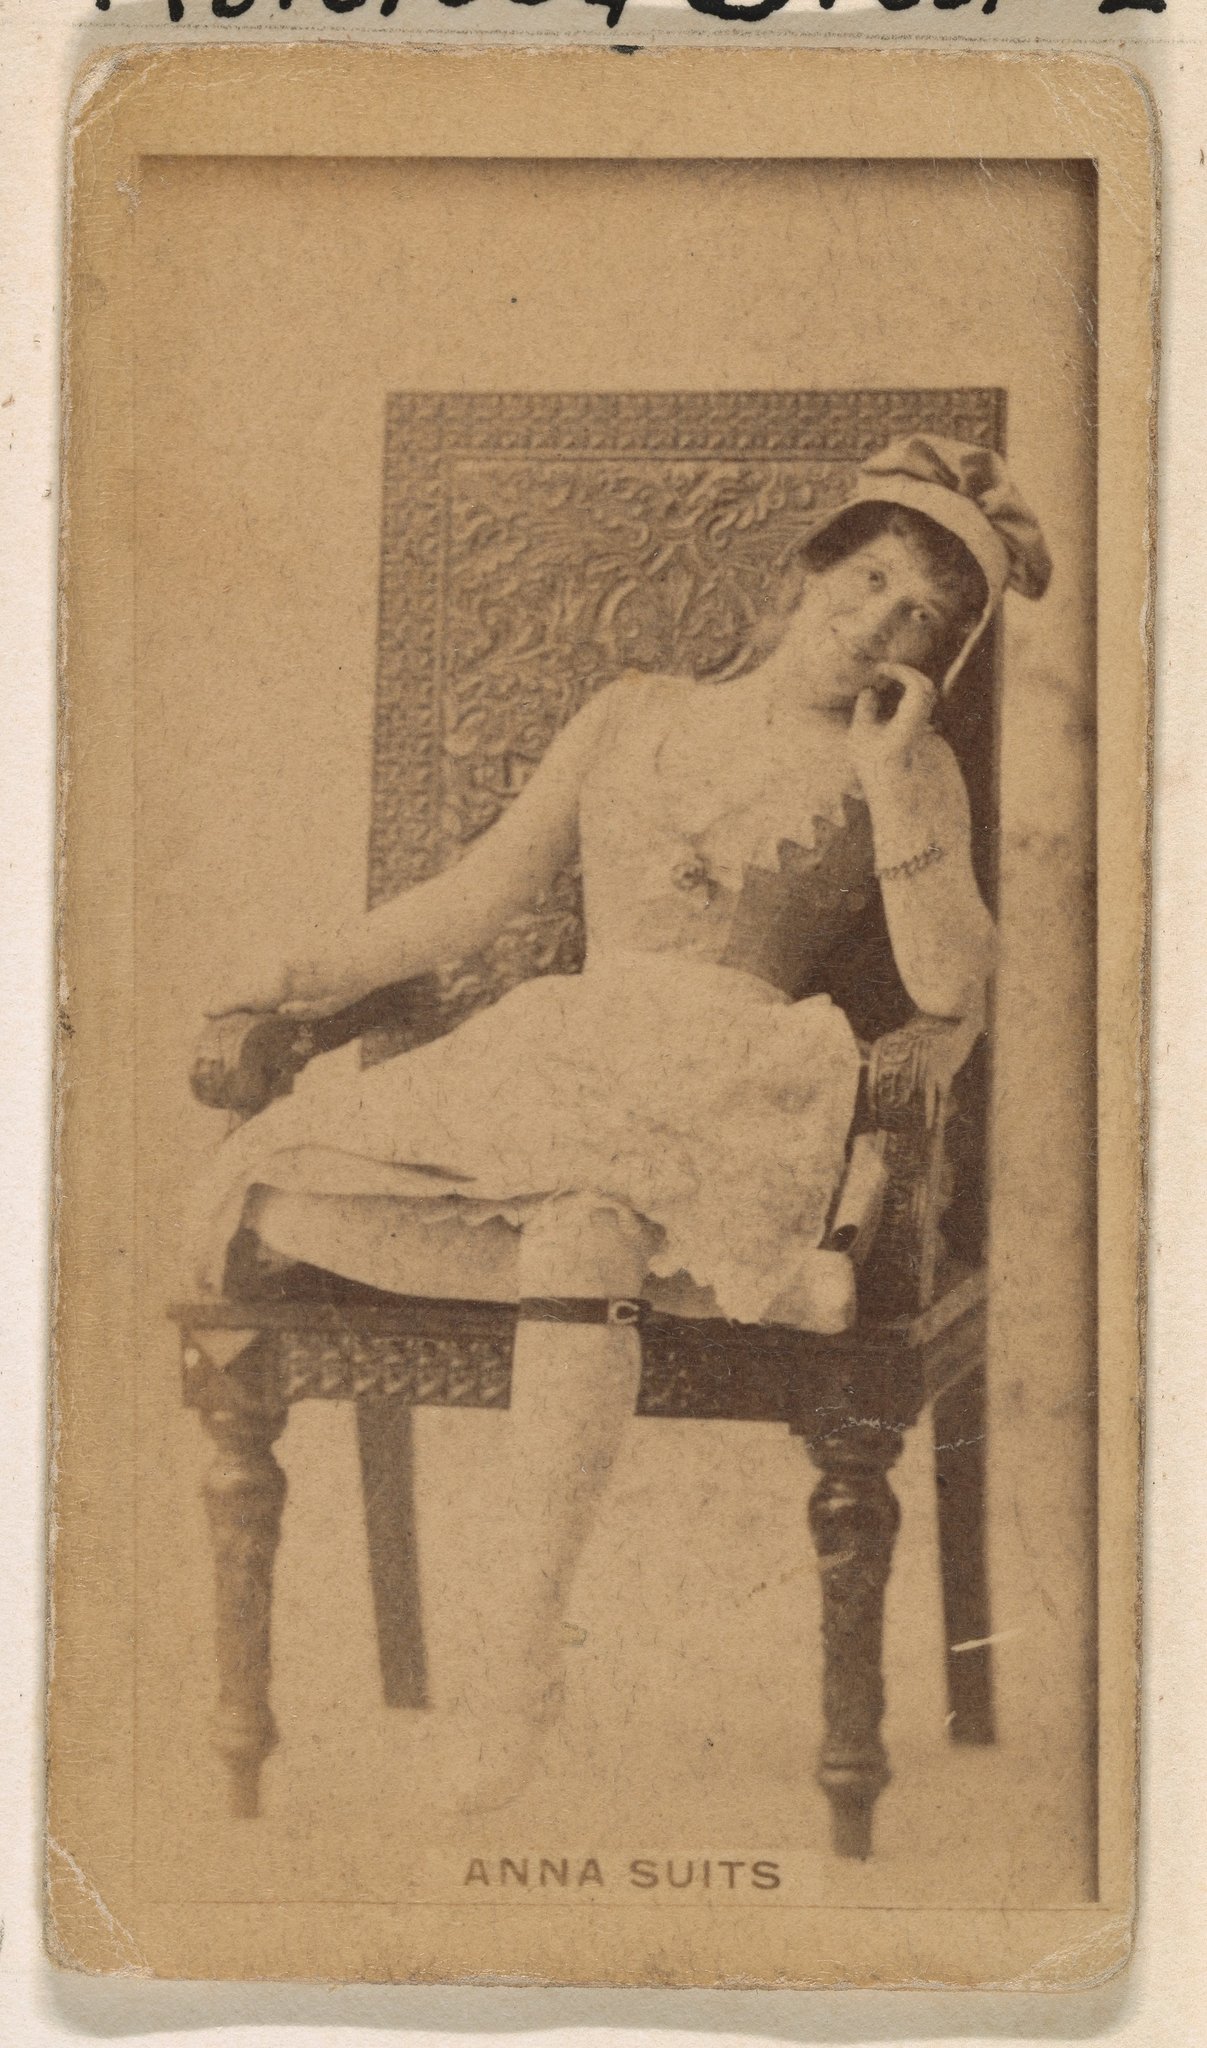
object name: photograph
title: Anna Suits, from the Actresses series (N245) issued by Kinney Brothers to promote Sweet Caporal Cigarettes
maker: kinney brothers tobacco company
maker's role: publisher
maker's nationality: american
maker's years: 1869-2011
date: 1890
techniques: albumen silver print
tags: portraits,women,actresses